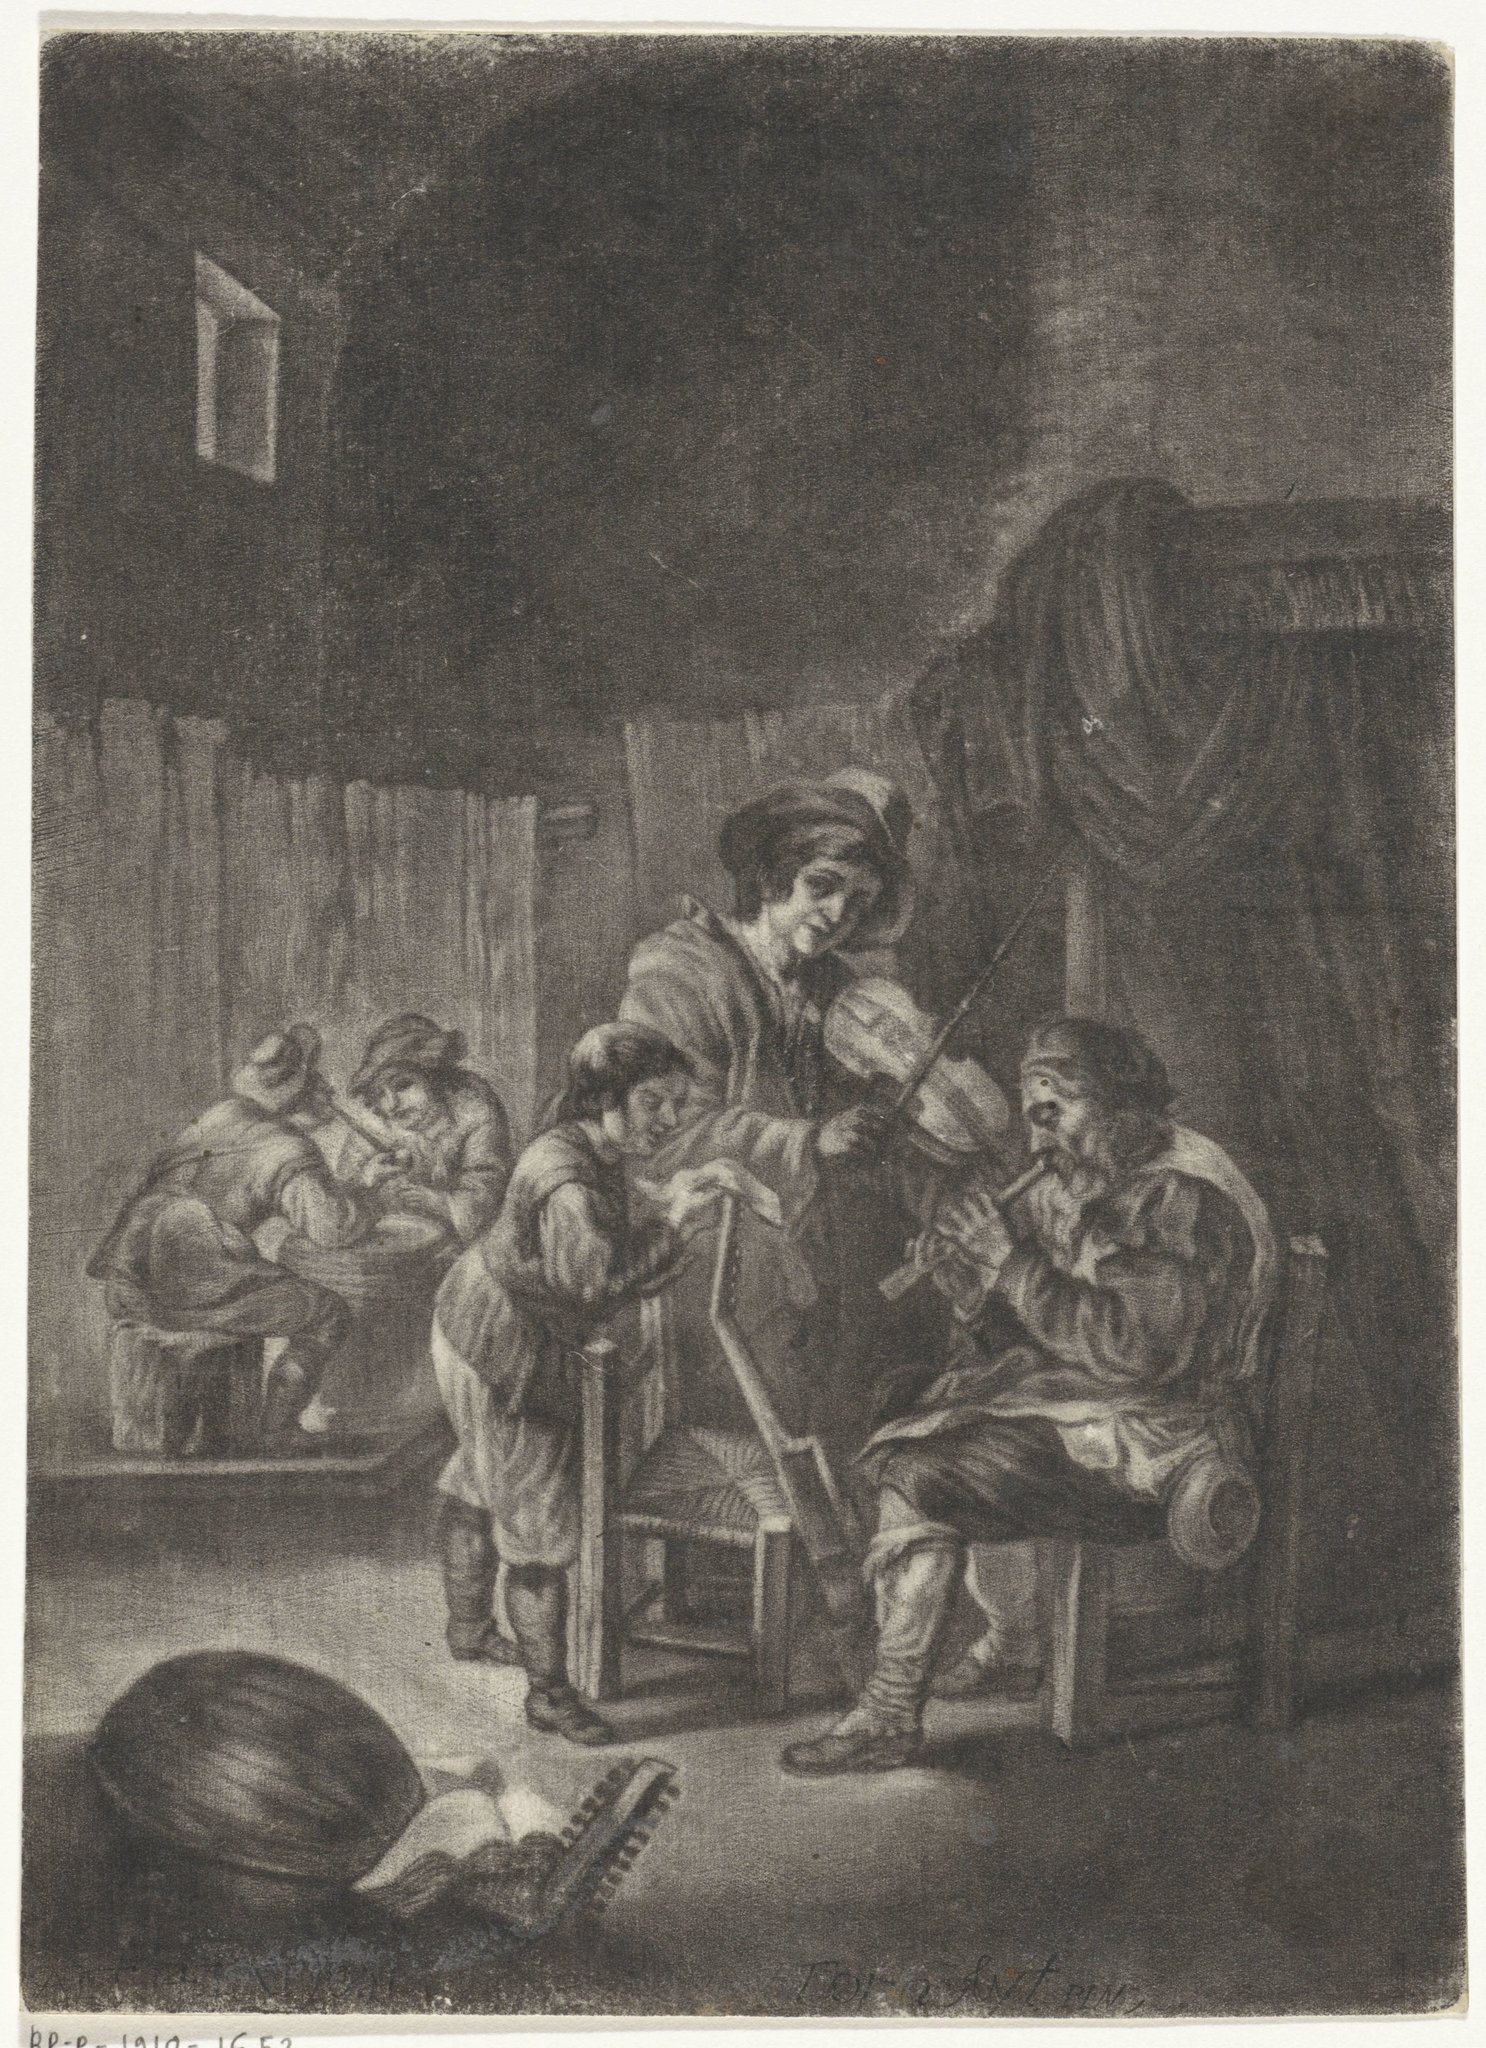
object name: print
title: Muzikanten in een herberg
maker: Anonymous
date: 1650-1800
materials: paper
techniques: mezzotint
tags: inn, coffee-house, public house, etc., pipe ~ tobacco, more than one musician with instrument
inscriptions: inscription, collector's mark: Lugt 2228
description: In een herberg maken drie mannen muziek. Een jongen zingt, een oude man speelt fluit en de derde man bespeelt een viool. Op de achtergrond twee pijprokende mannen.